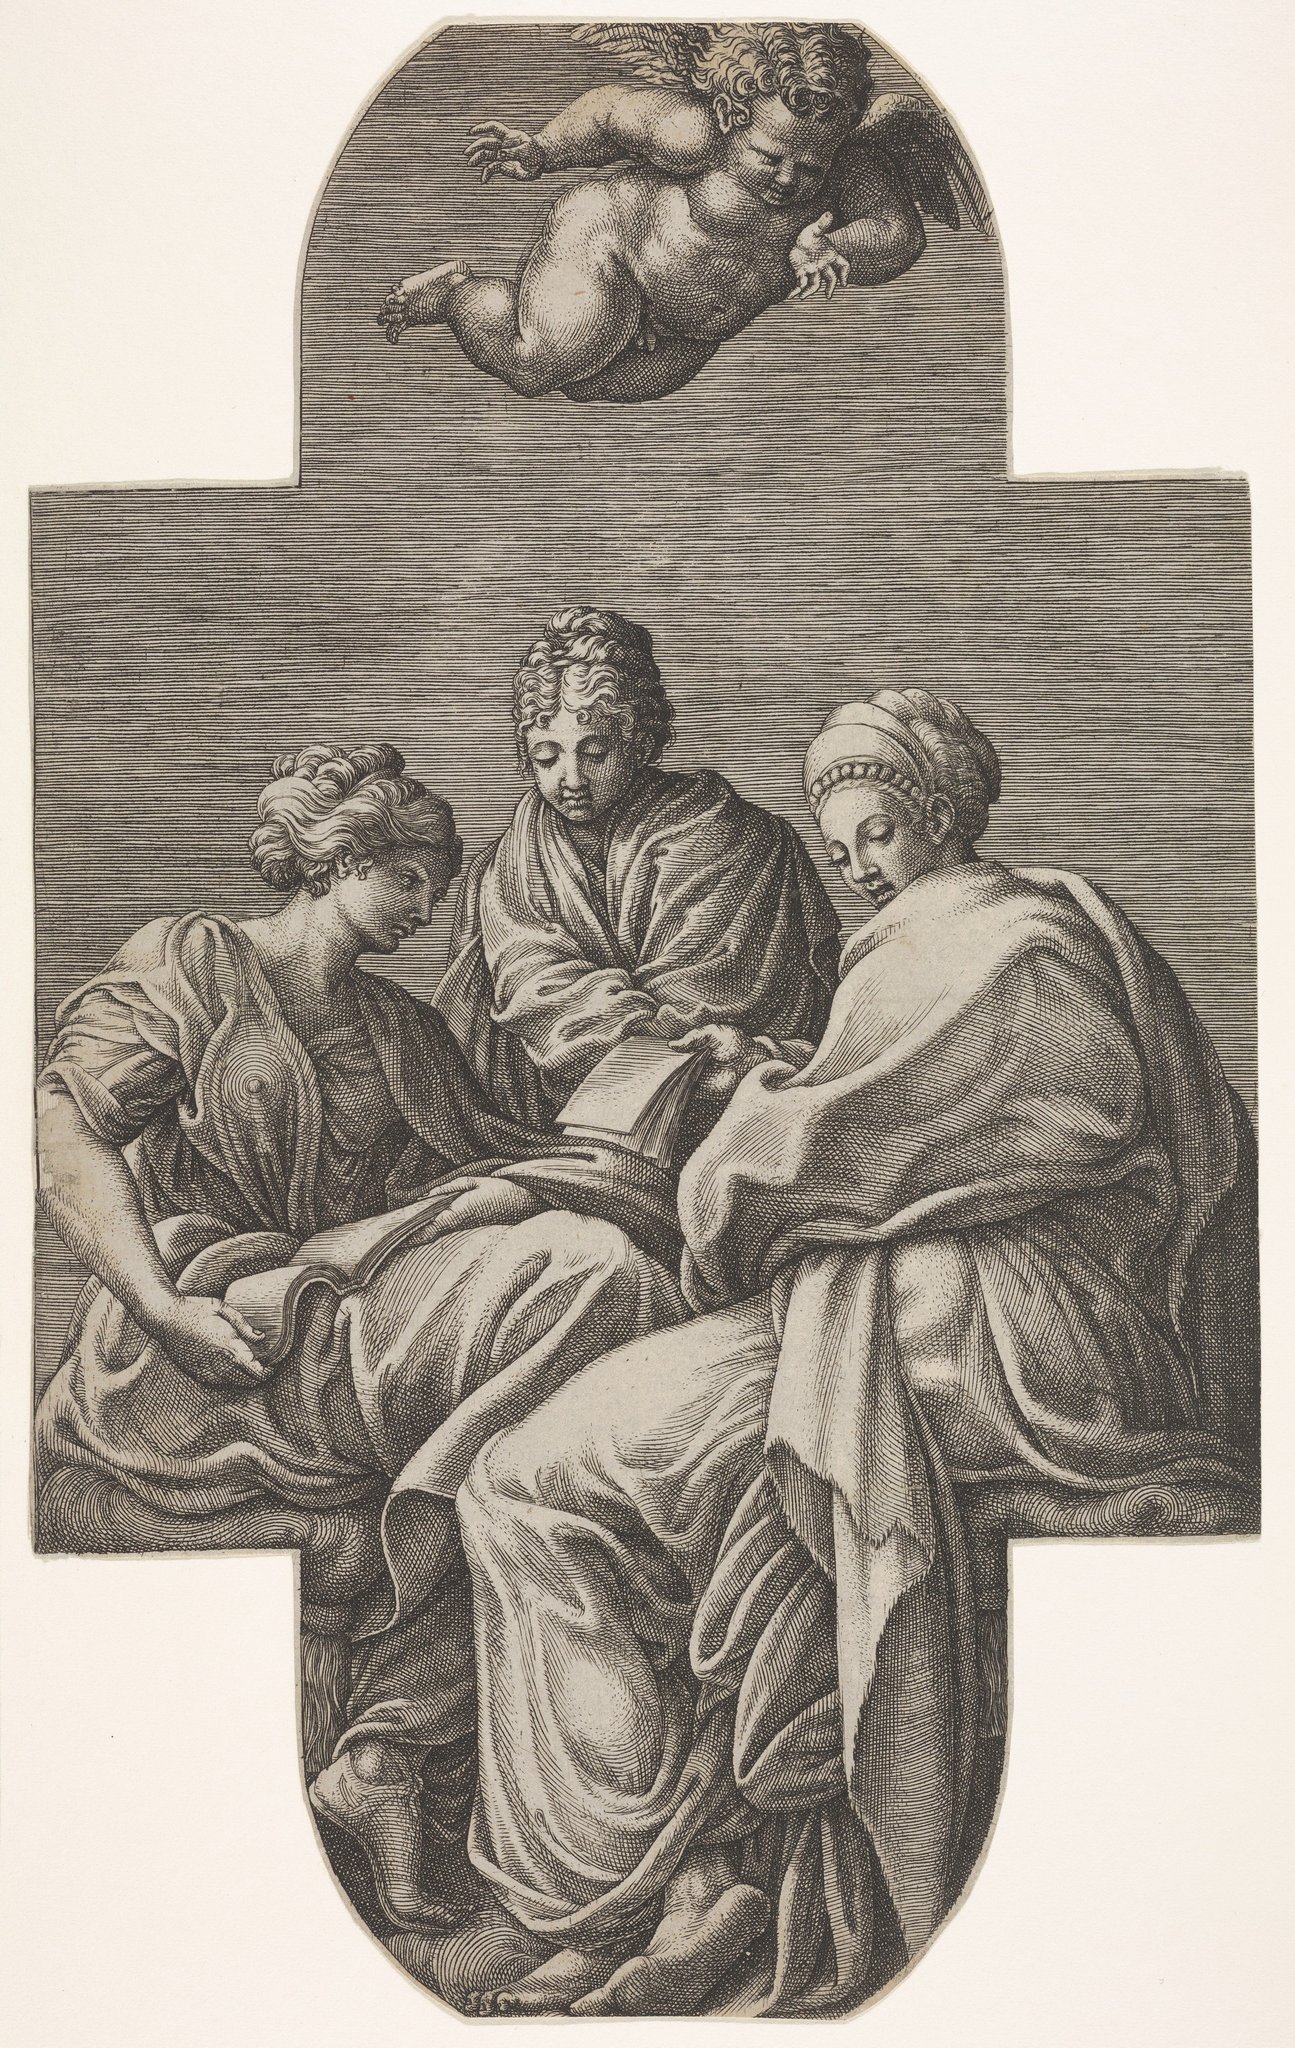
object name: print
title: Three Muses seated underneath a flying putto who gestures downward, a cruciform composition, from a series of eight compositions after Francesco Primaticcio's designs for the ceiling of the Ulysses Gallery (destroyed 1738-39) at Fontainebleau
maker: giorgio ghisi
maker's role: artist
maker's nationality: italian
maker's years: 1515-1582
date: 1560-1569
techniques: engraving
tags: muses